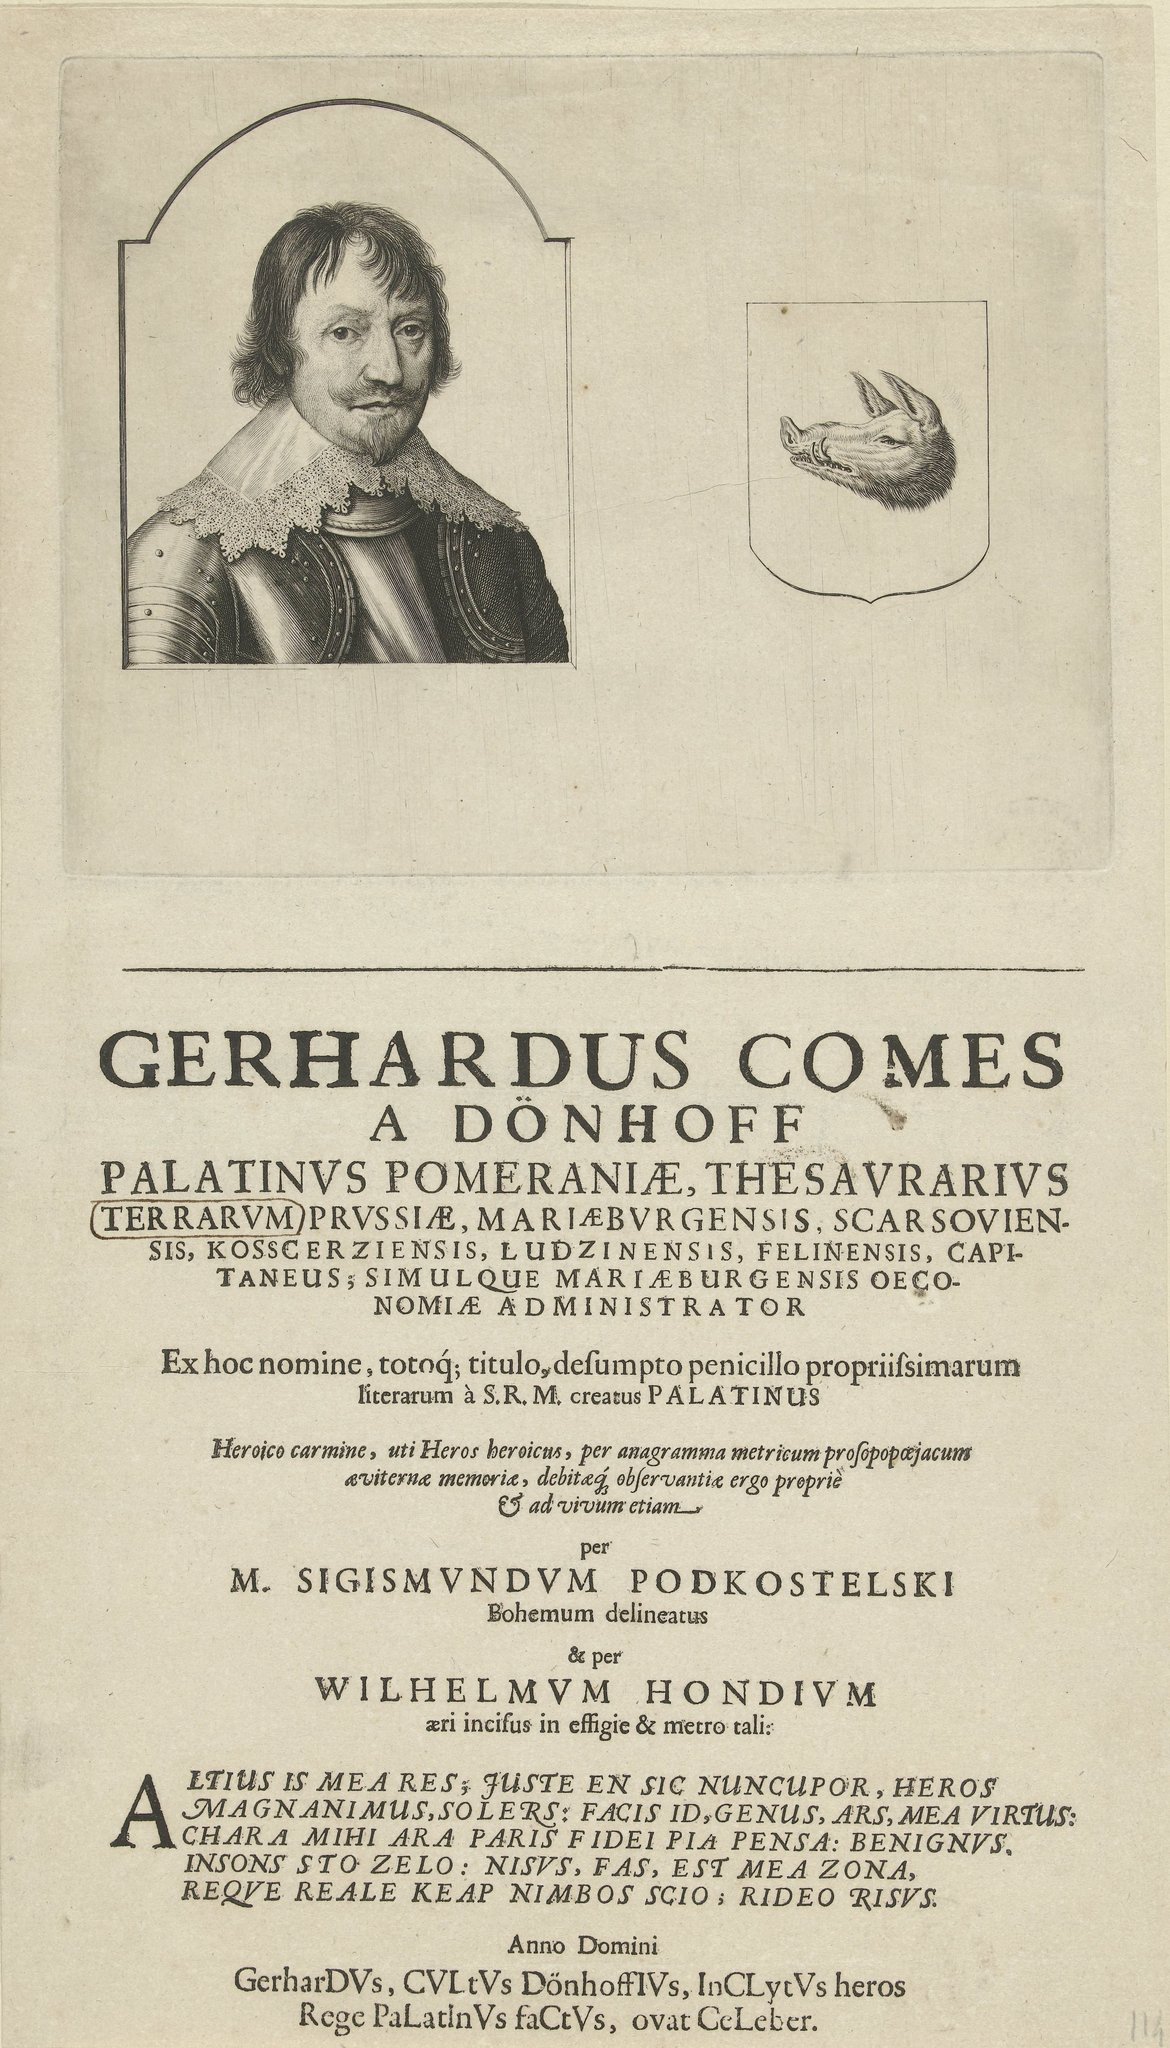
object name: print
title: Christus voor Pilatus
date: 1619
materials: paper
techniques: engraving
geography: netherlands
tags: christ before pontius pilate (matthew 27:11-26; mark 15:2-15; luke 23:2-7, 23:13-25; john 18:28 - 19:16)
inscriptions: collector's mark: Lugt 2228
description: Prent uit serie van twaalf prenten met scènes uit de Passie. Reeks geïnspireerd door de prenten van Hendrick Goltzius en Lucas van Leyden.